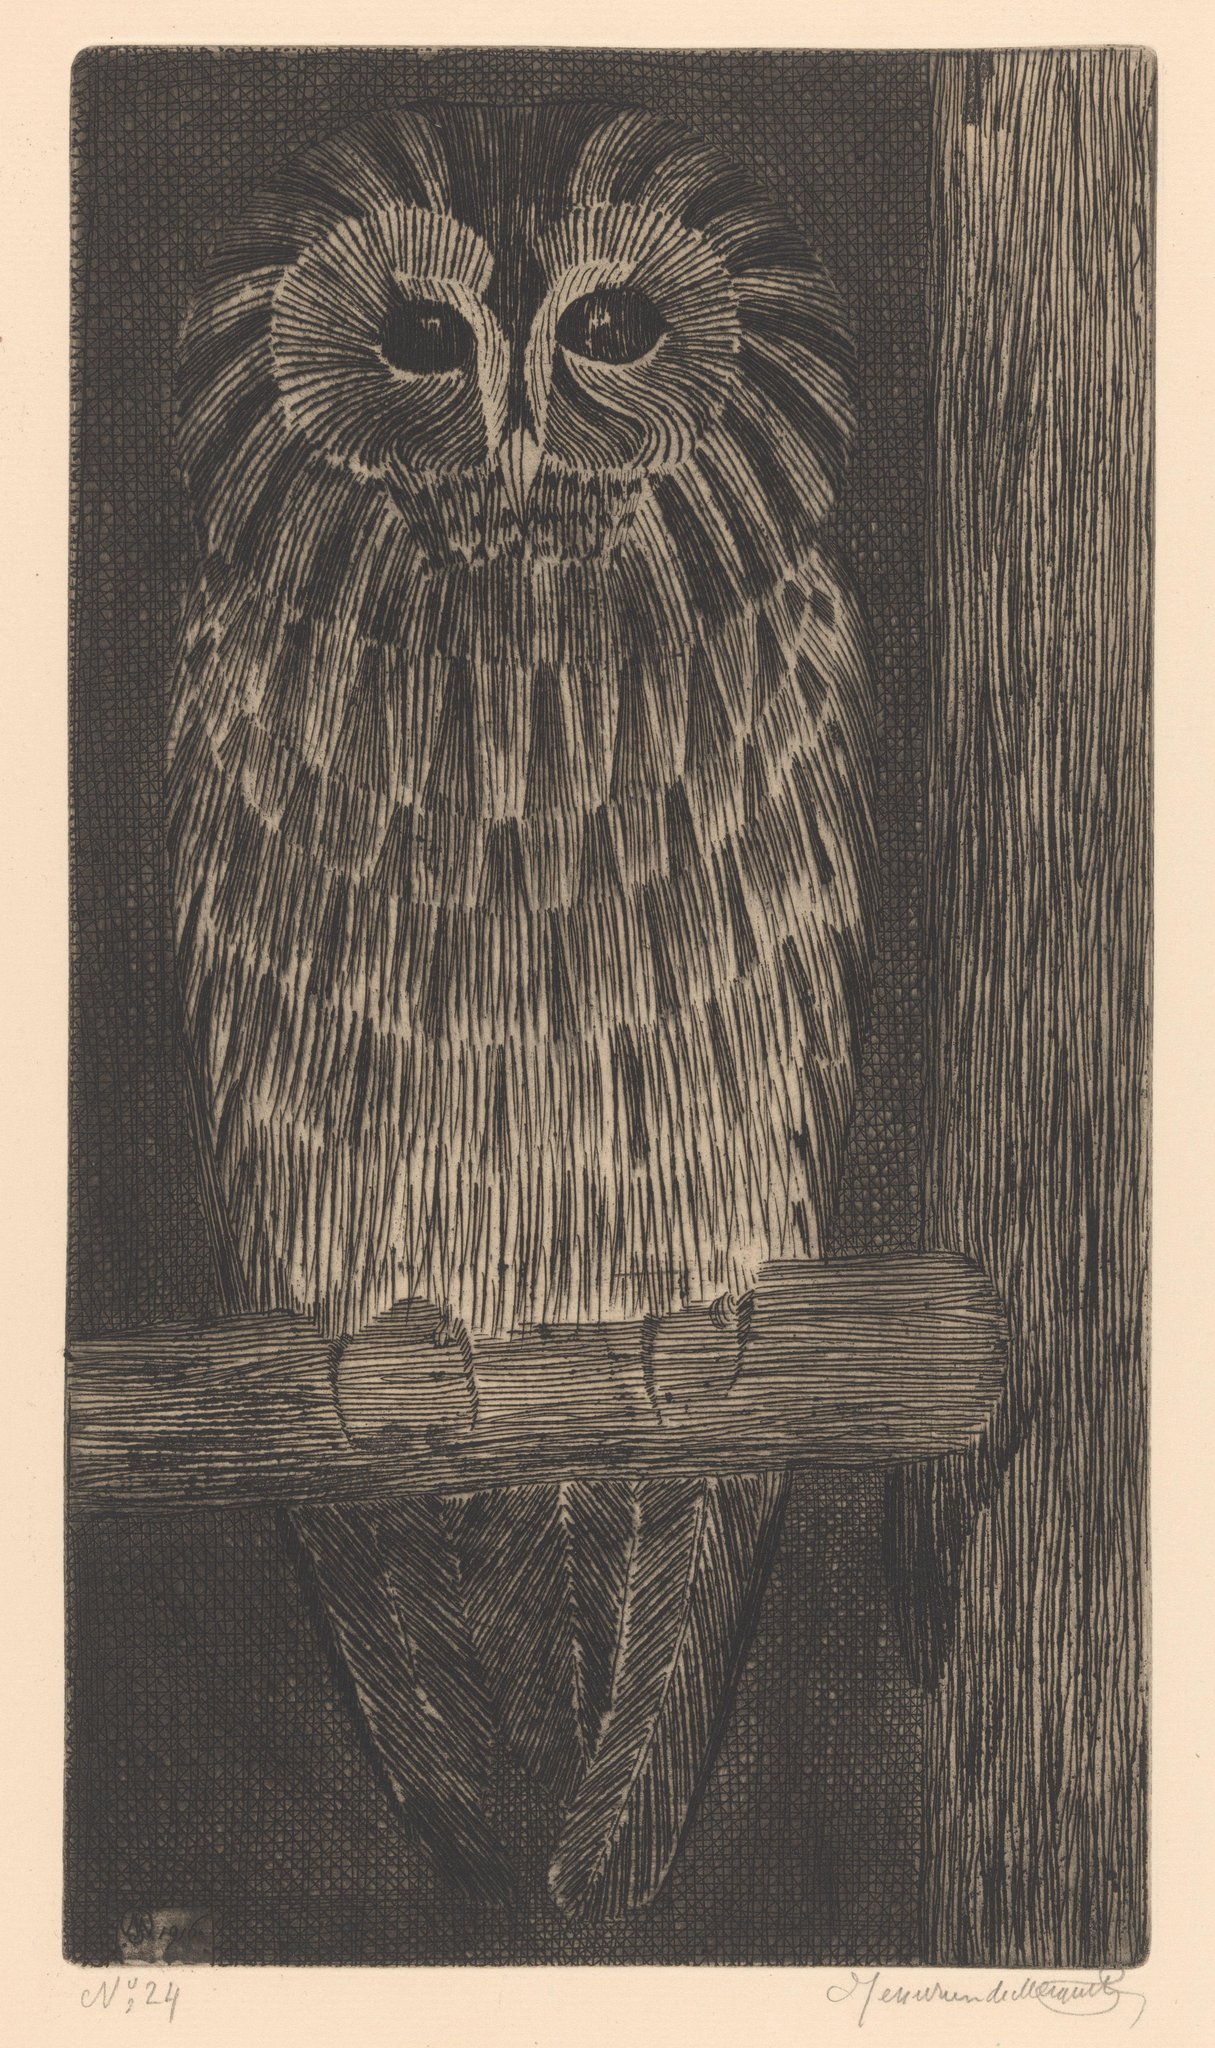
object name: print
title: Bosuil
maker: samuel jessurun de mesquita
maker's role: draughtsman, print maker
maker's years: 1868-1944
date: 1916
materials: paper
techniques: etching, intaglio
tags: owls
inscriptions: collector's mark: Lugt 733, collector's mark: Lugt 2228